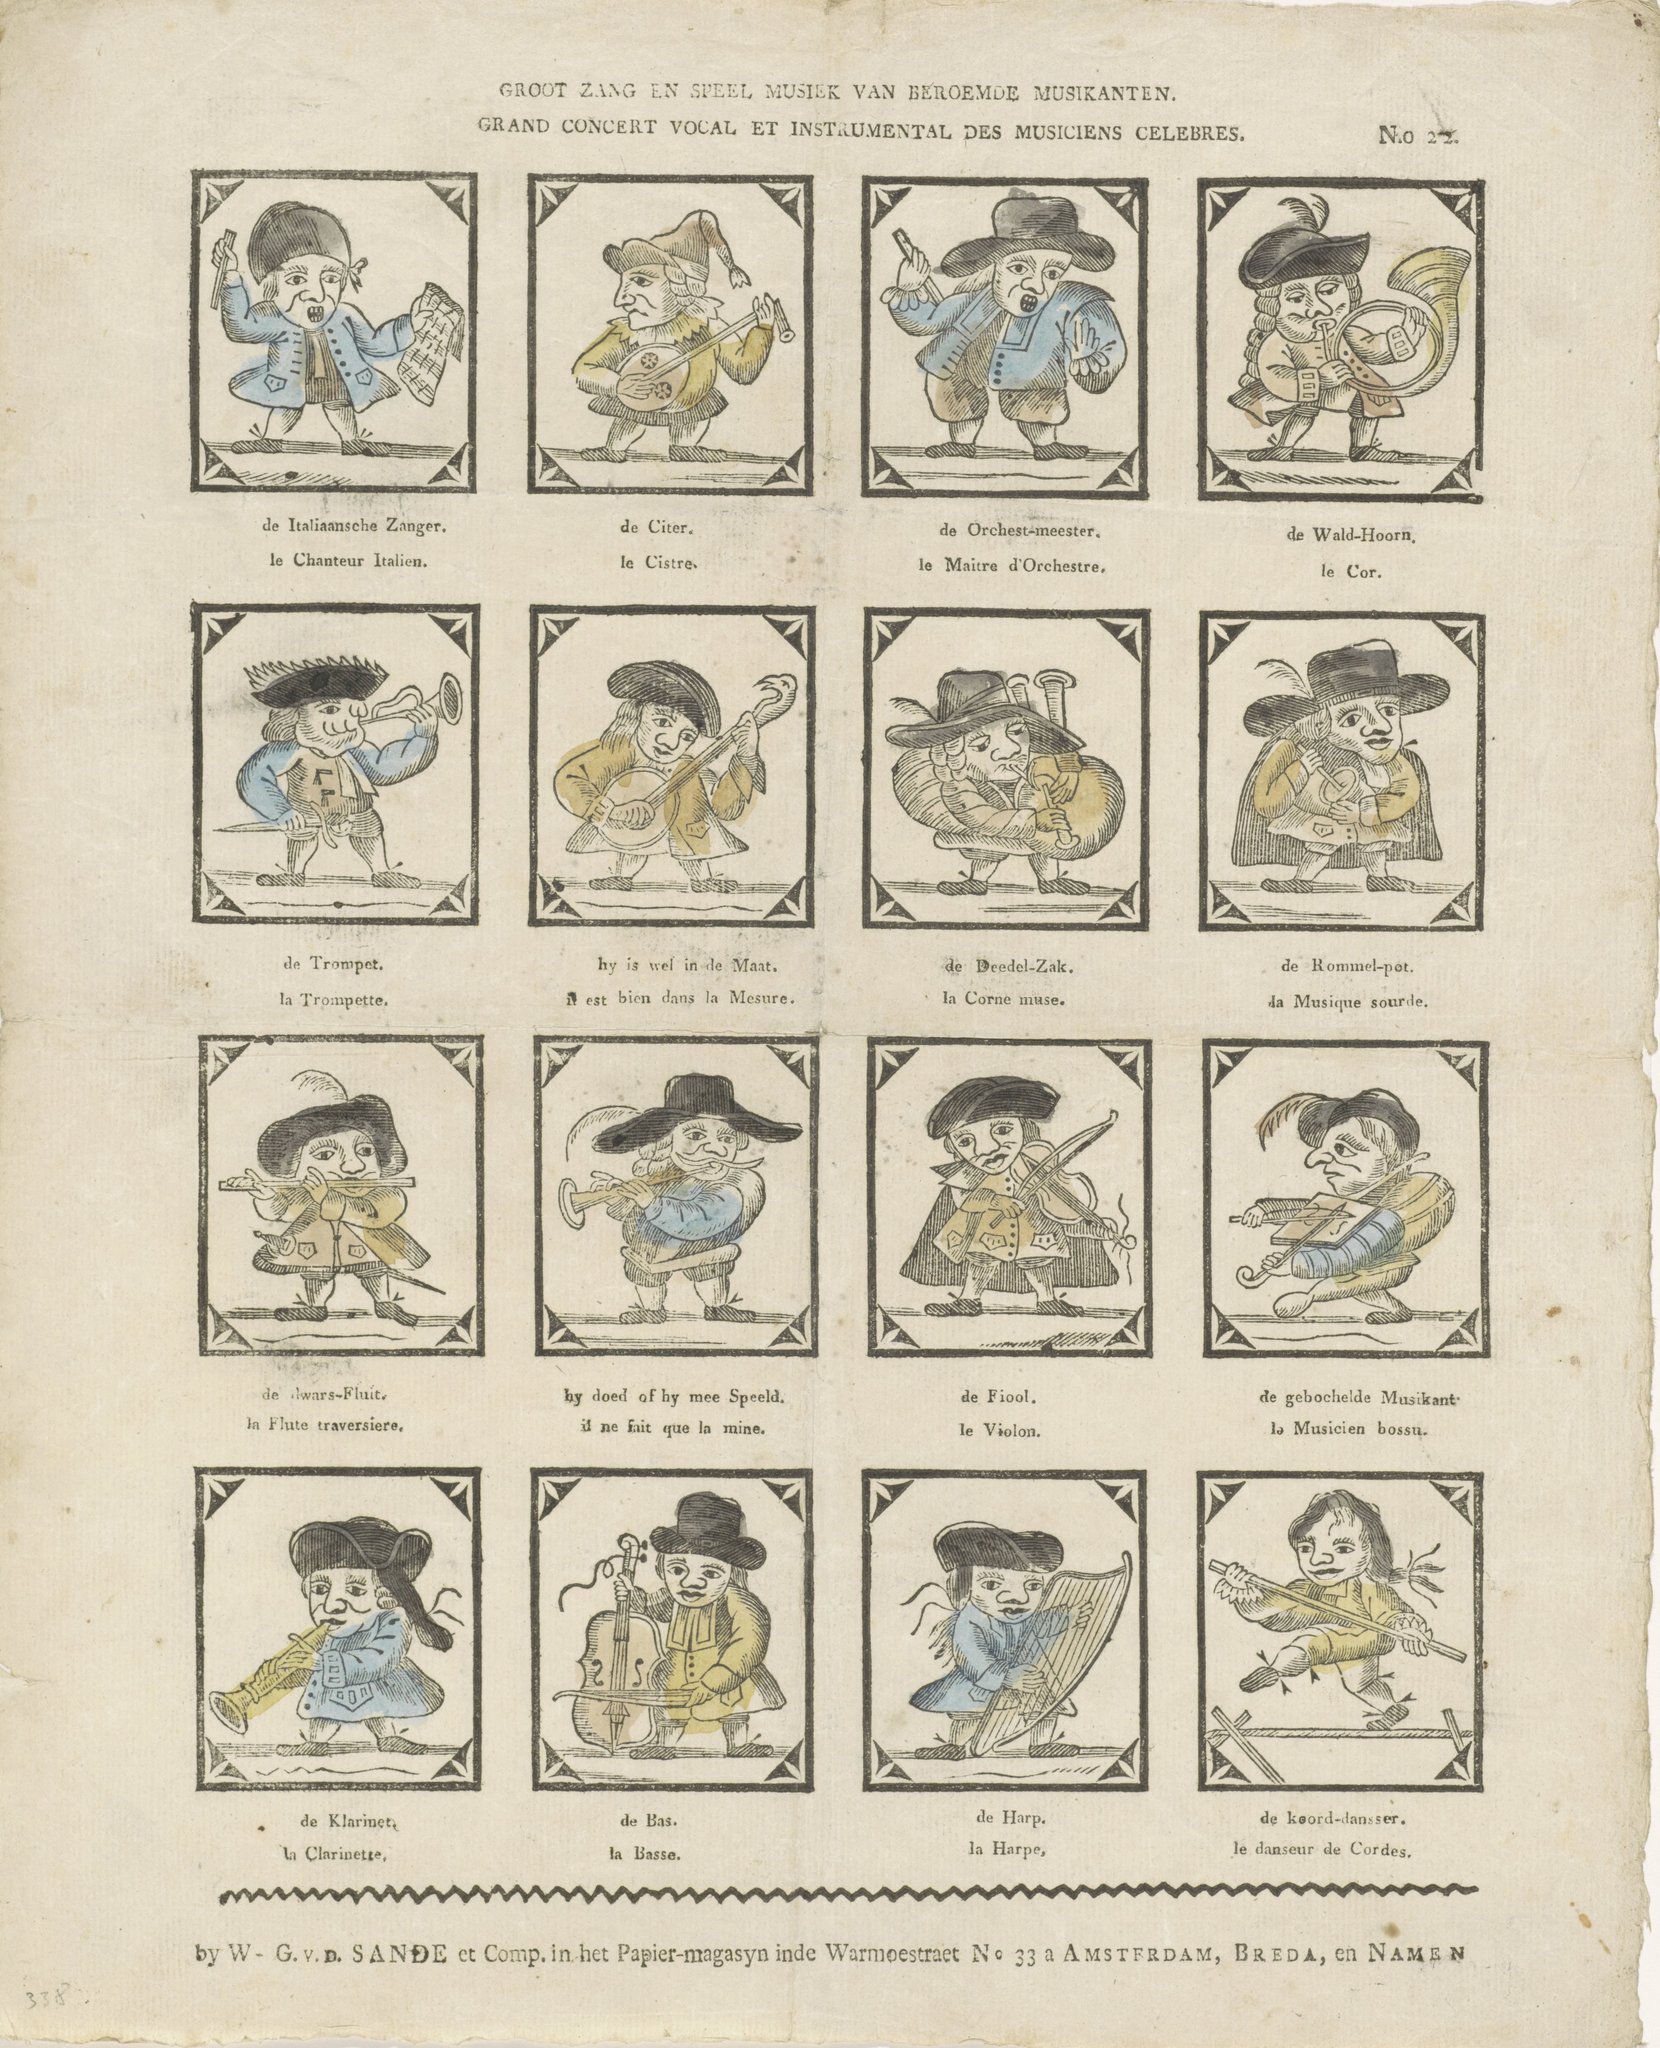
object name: popular print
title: Groot zang en speel musiek van beroemde musikanten / Grand concert vocal et instrumental des musiciens celebres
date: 1806-1814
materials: paper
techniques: colour, letterpress printing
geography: europe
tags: musical instruments; group of musical instruments, musician, ropery, rope-walk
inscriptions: collector's mark: Lugt 2760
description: Blad 16 voorstellingen van muzikanten met instrumenten, waaronder een citer, een hoorn, een doedelzak en een klarinet. Rechtsonder ook een koorddanser. Onder elke voorstelling een onderschrift in het Nederlands en in het Frans. Genummerd rechtsboven: No. 22.